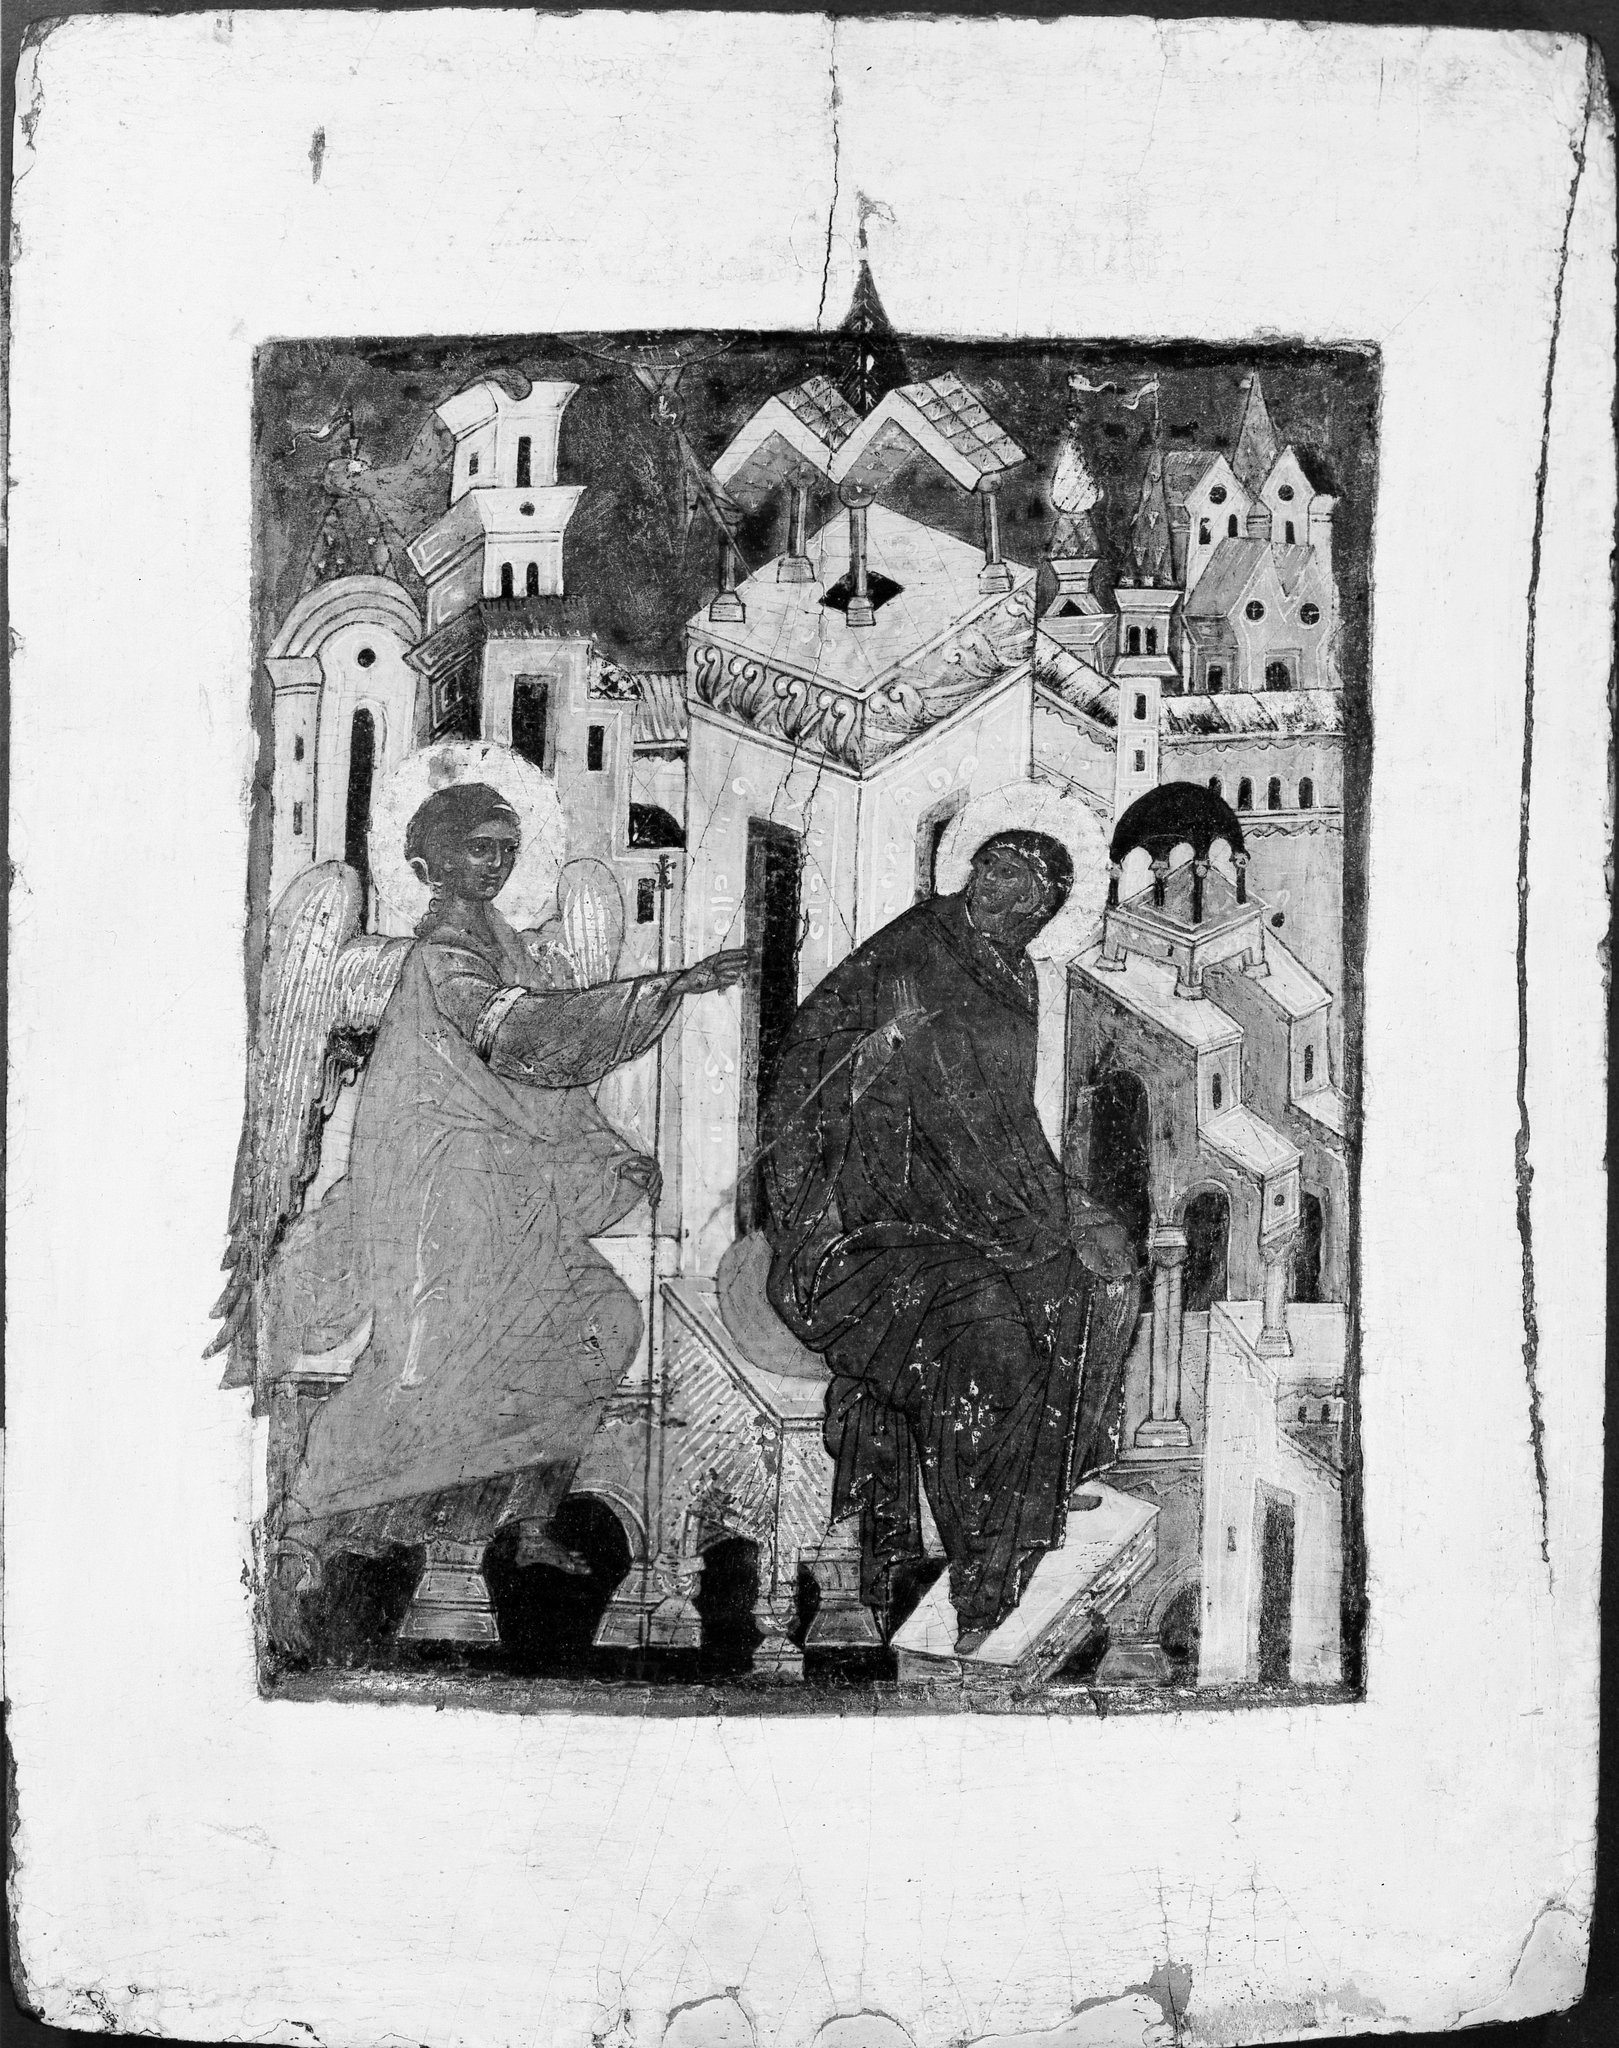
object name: painting, icon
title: The Annunciation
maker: russian painter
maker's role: artist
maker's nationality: russian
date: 1550-1599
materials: paint, wood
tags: angels,virgin mary,archangel gabriel,annunciation